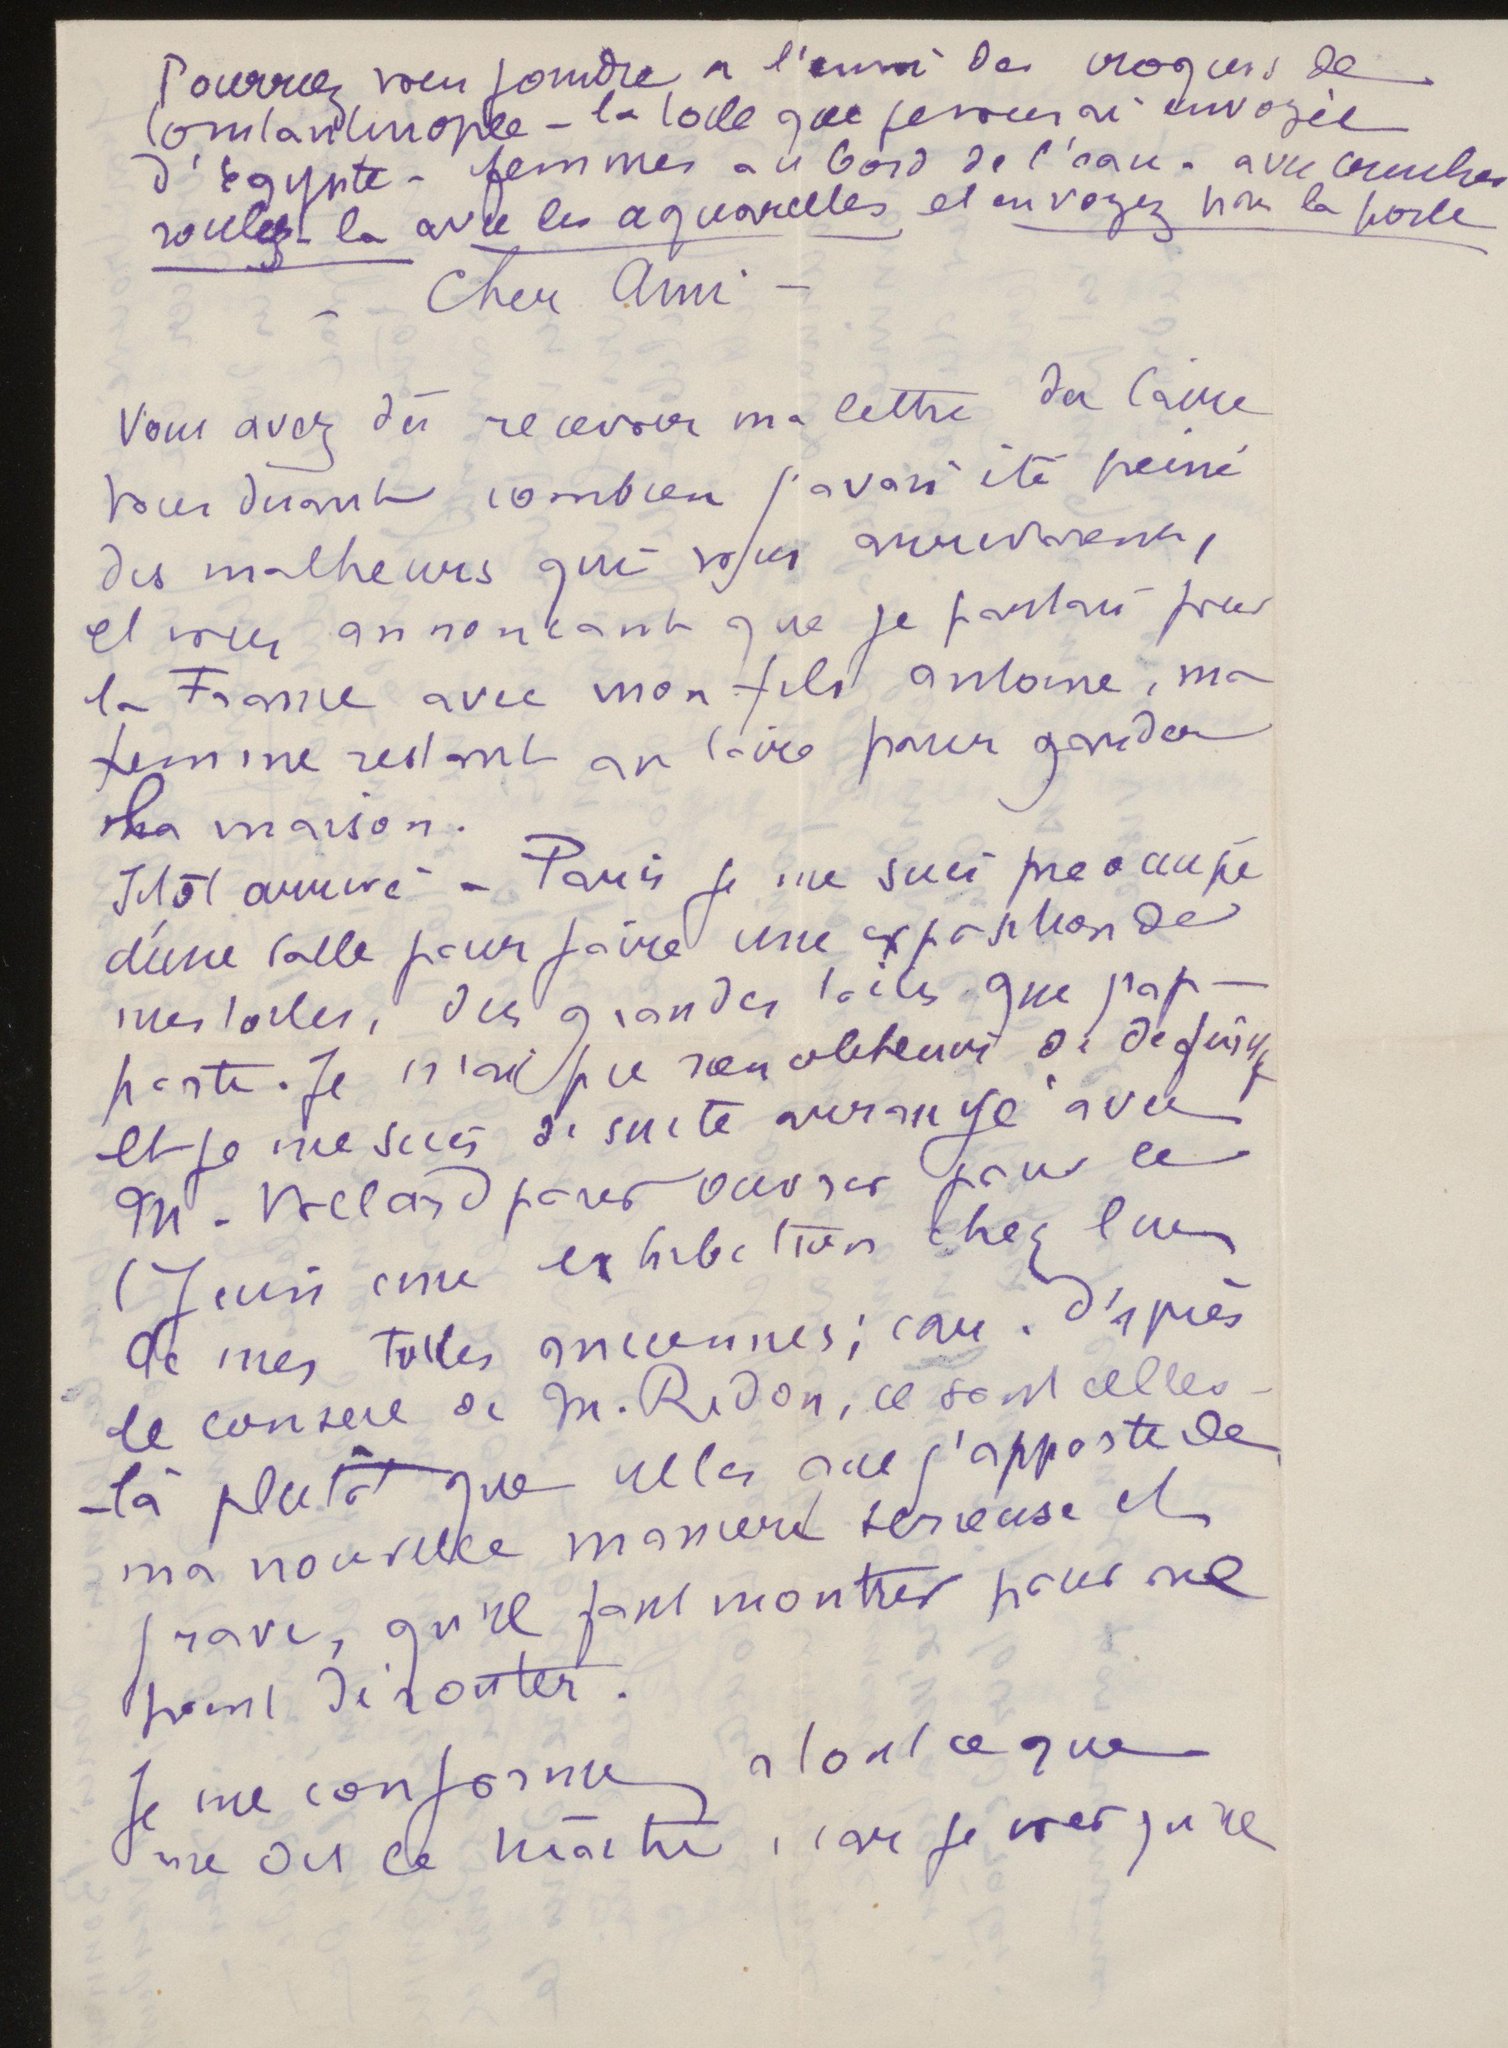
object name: letter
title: Brief aan Andries Bonger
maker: émile bernard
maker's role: print maker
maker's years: 1868-1941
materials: ink, paper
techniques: pen, writing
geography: colombes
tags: odilon redon, print maker, henri jean guillaume martin, paul sérusier, paul signac, sculptor, ignacio zuloaga, paul gauguin, rome, painter, alessandro turchi, pierre bonnard, paris, draughtsman, ferdinand roybet, venice, titiaan, amsterdam, andries bonger, anacapri, saar de swart, publisher, henri louis ambroise vollard, maurice denis, jacques-émile blanche, passions, emotions, affections, family life, painting (including book-illumination, miniature-painting), exhibition ~ art, italy